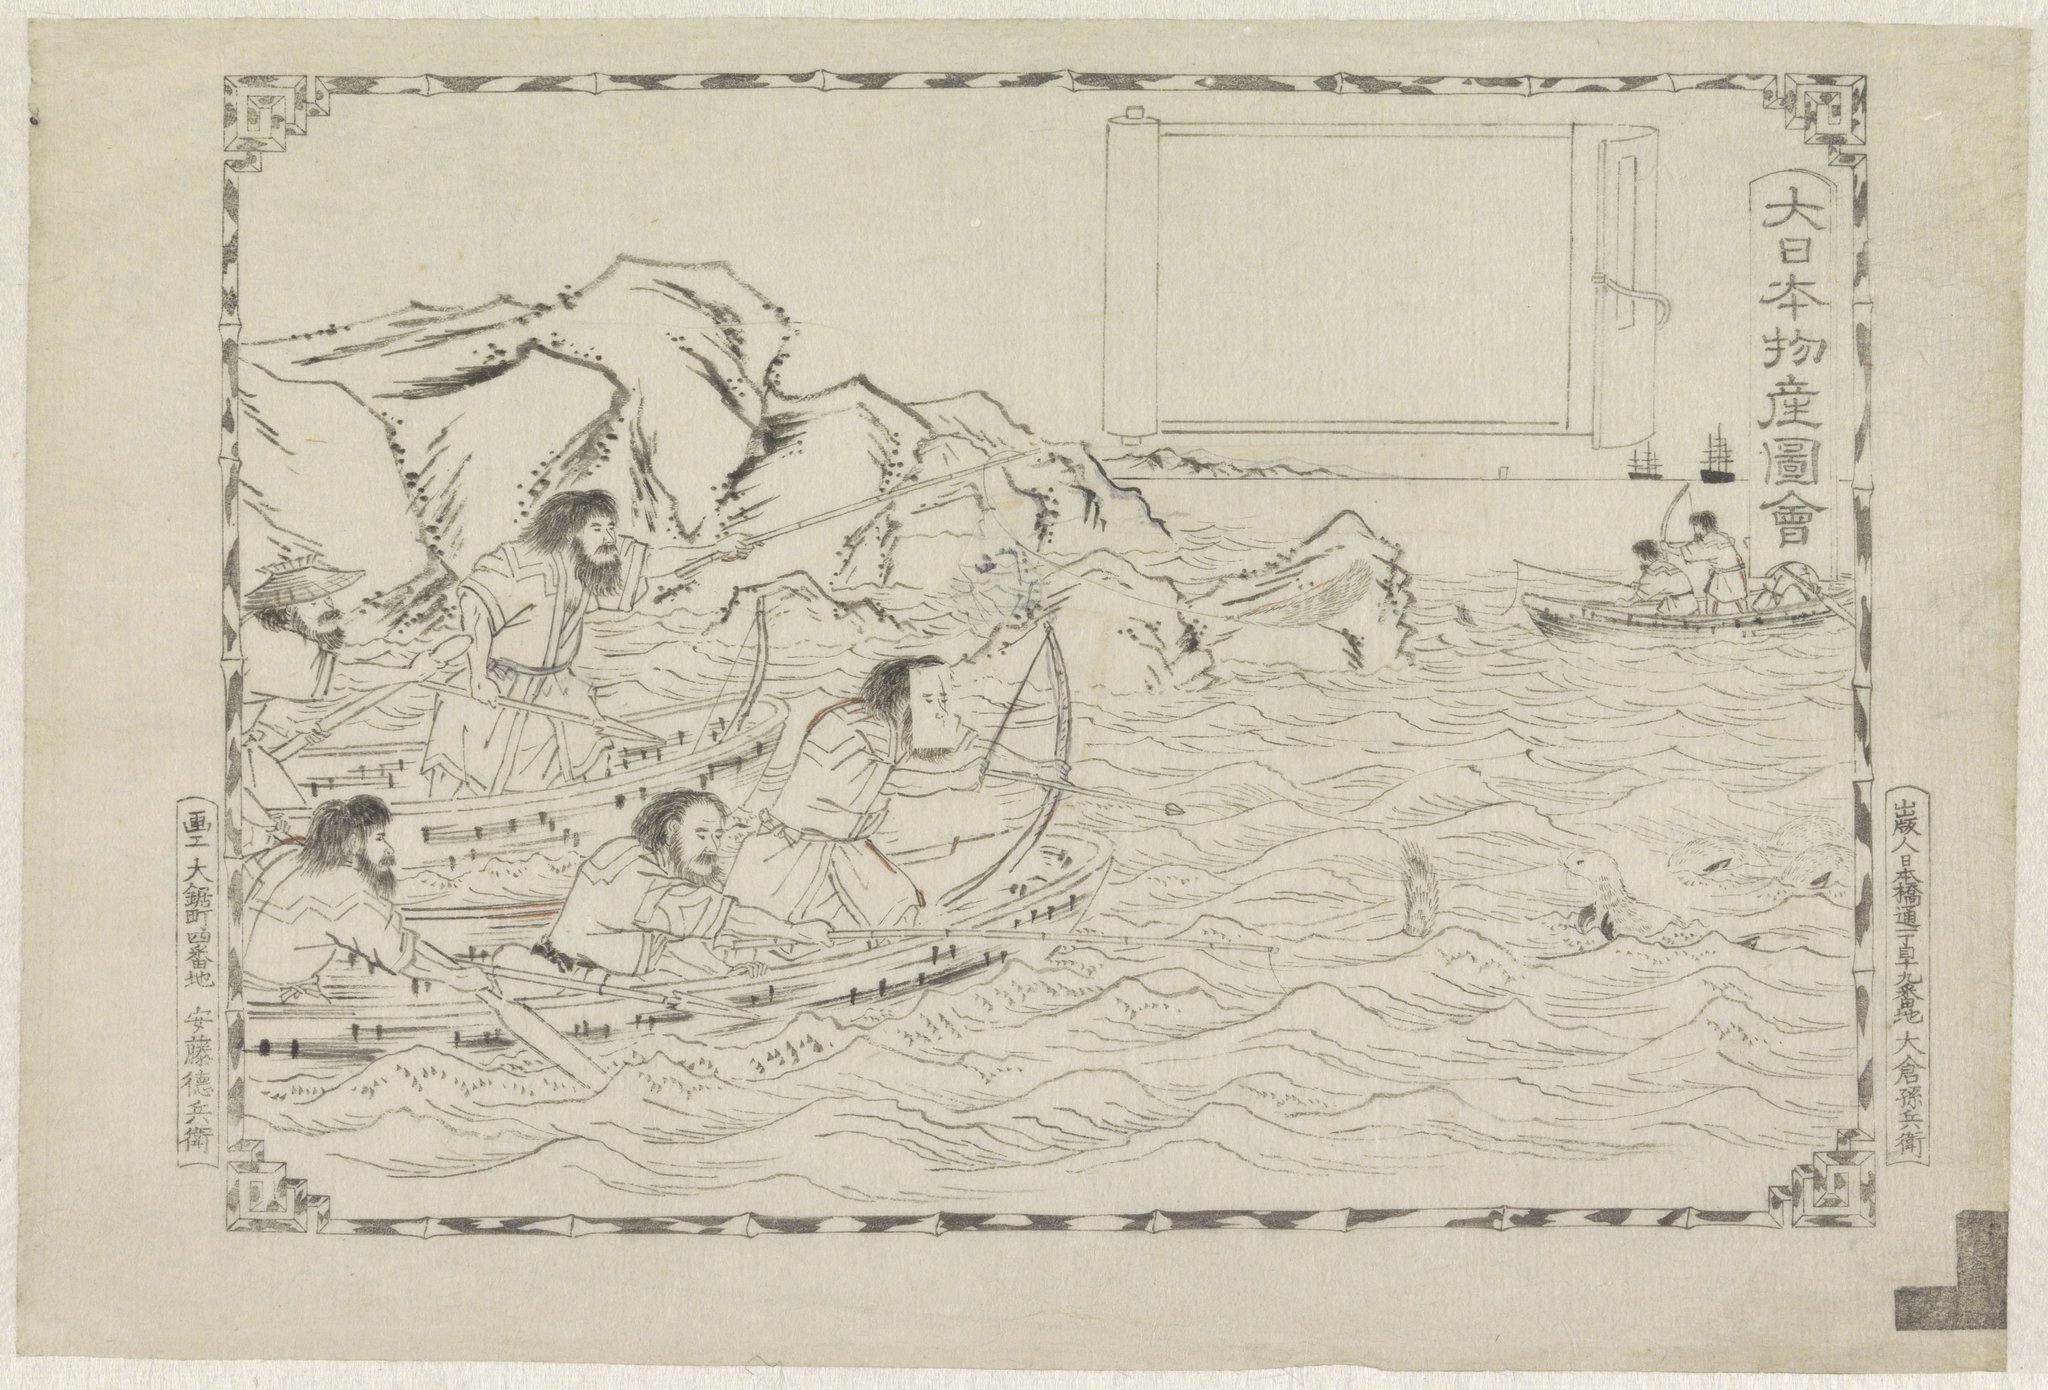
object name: drawing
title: Robbenjacht vanuit een roeibootje in imitatiebamboe omlijsting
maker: utagawa hiroshige (ii)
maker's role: print maker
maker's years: 1826-1869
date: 1836-1869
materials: ink, paper, pencil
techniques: brush, pen